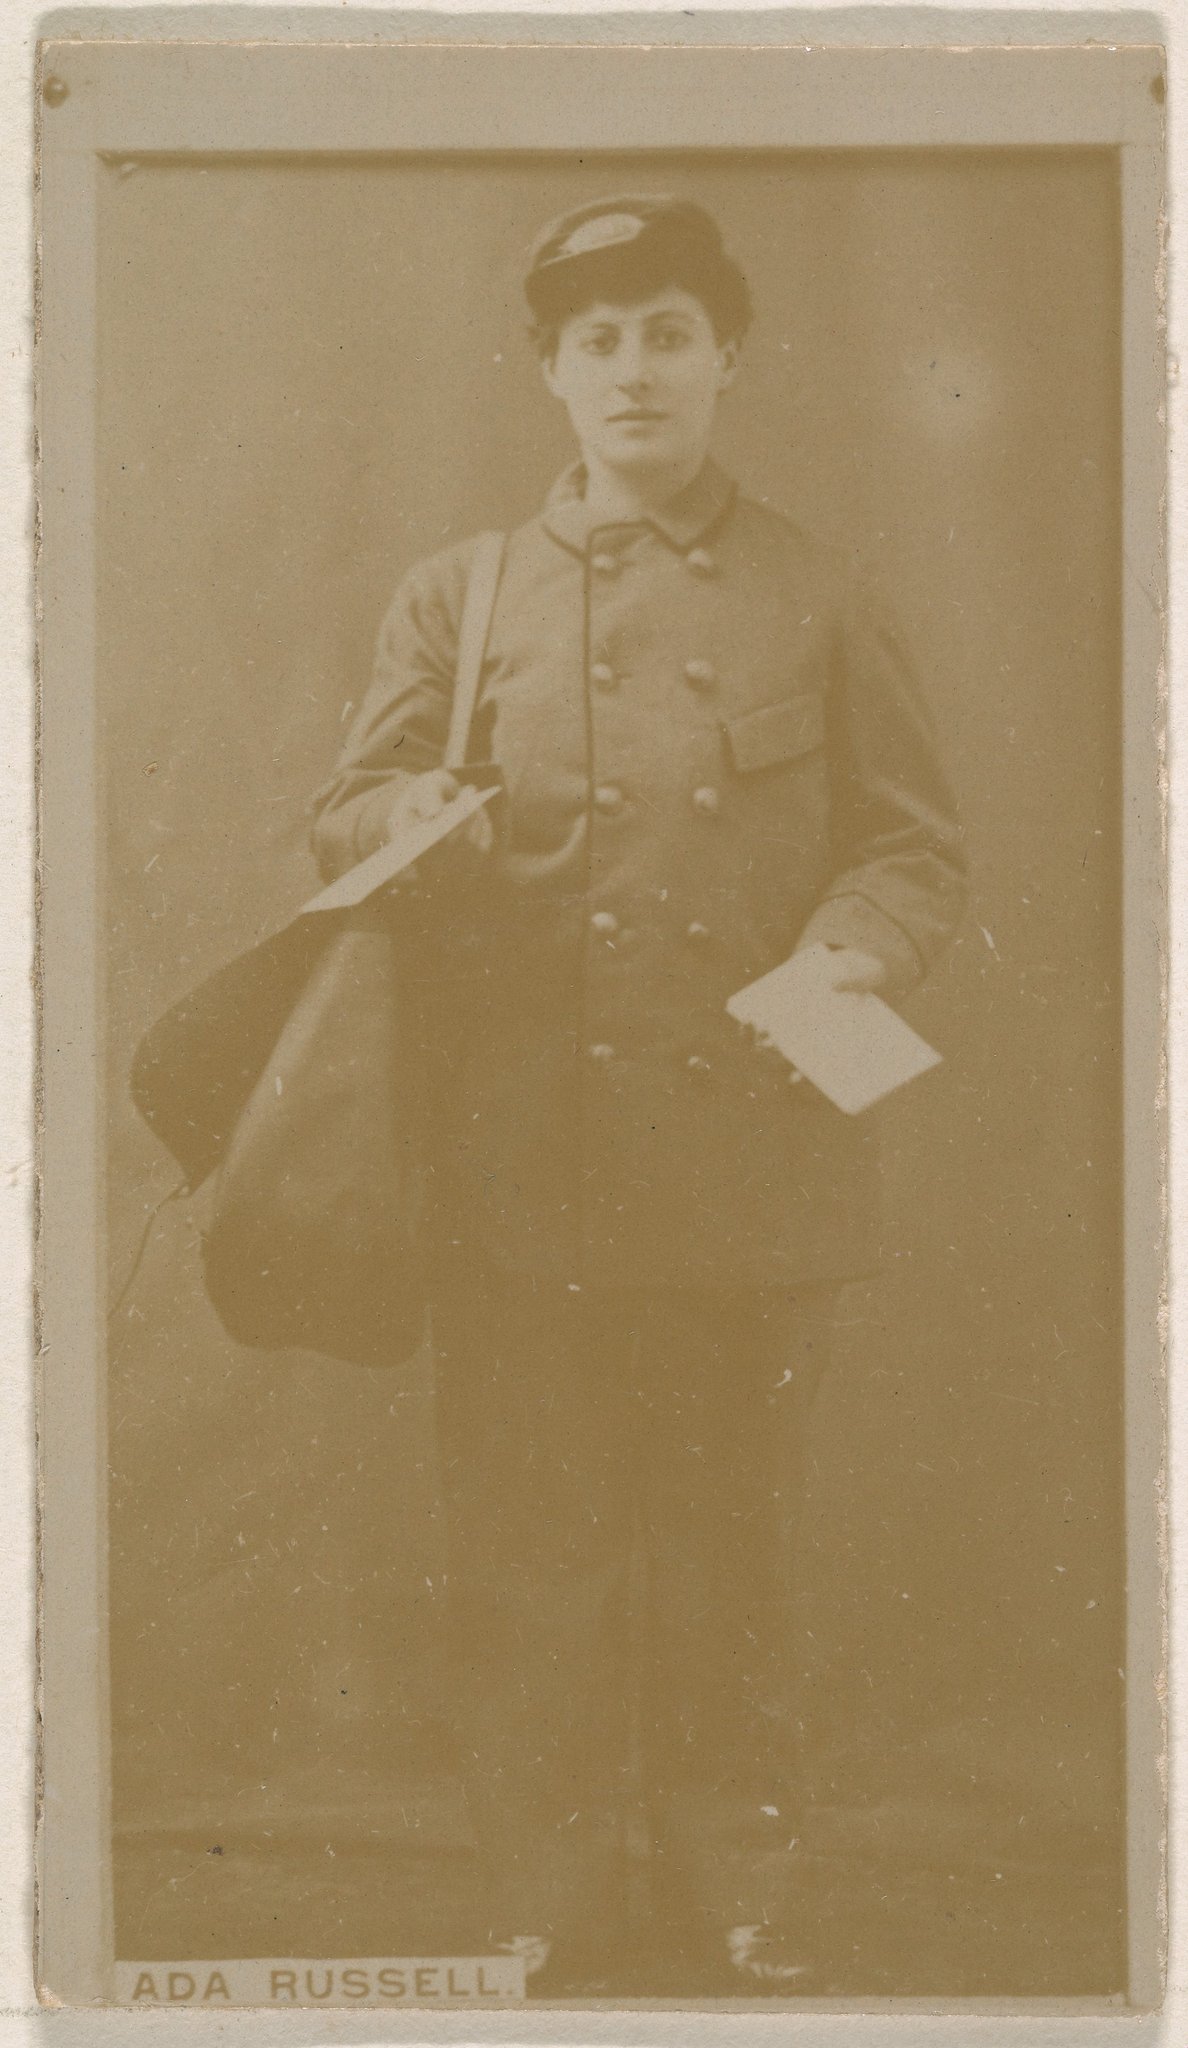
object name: photograph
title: Ada Russell, from the Actresses series (N245) issued by Kinney Brothers to promote Sweet Caporal Cigarettes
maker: kinney brothers tobacco company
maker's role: publisher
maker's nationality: american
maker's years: 1869-2011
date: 1890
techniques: albumen silver print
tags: portraits,women,actresses